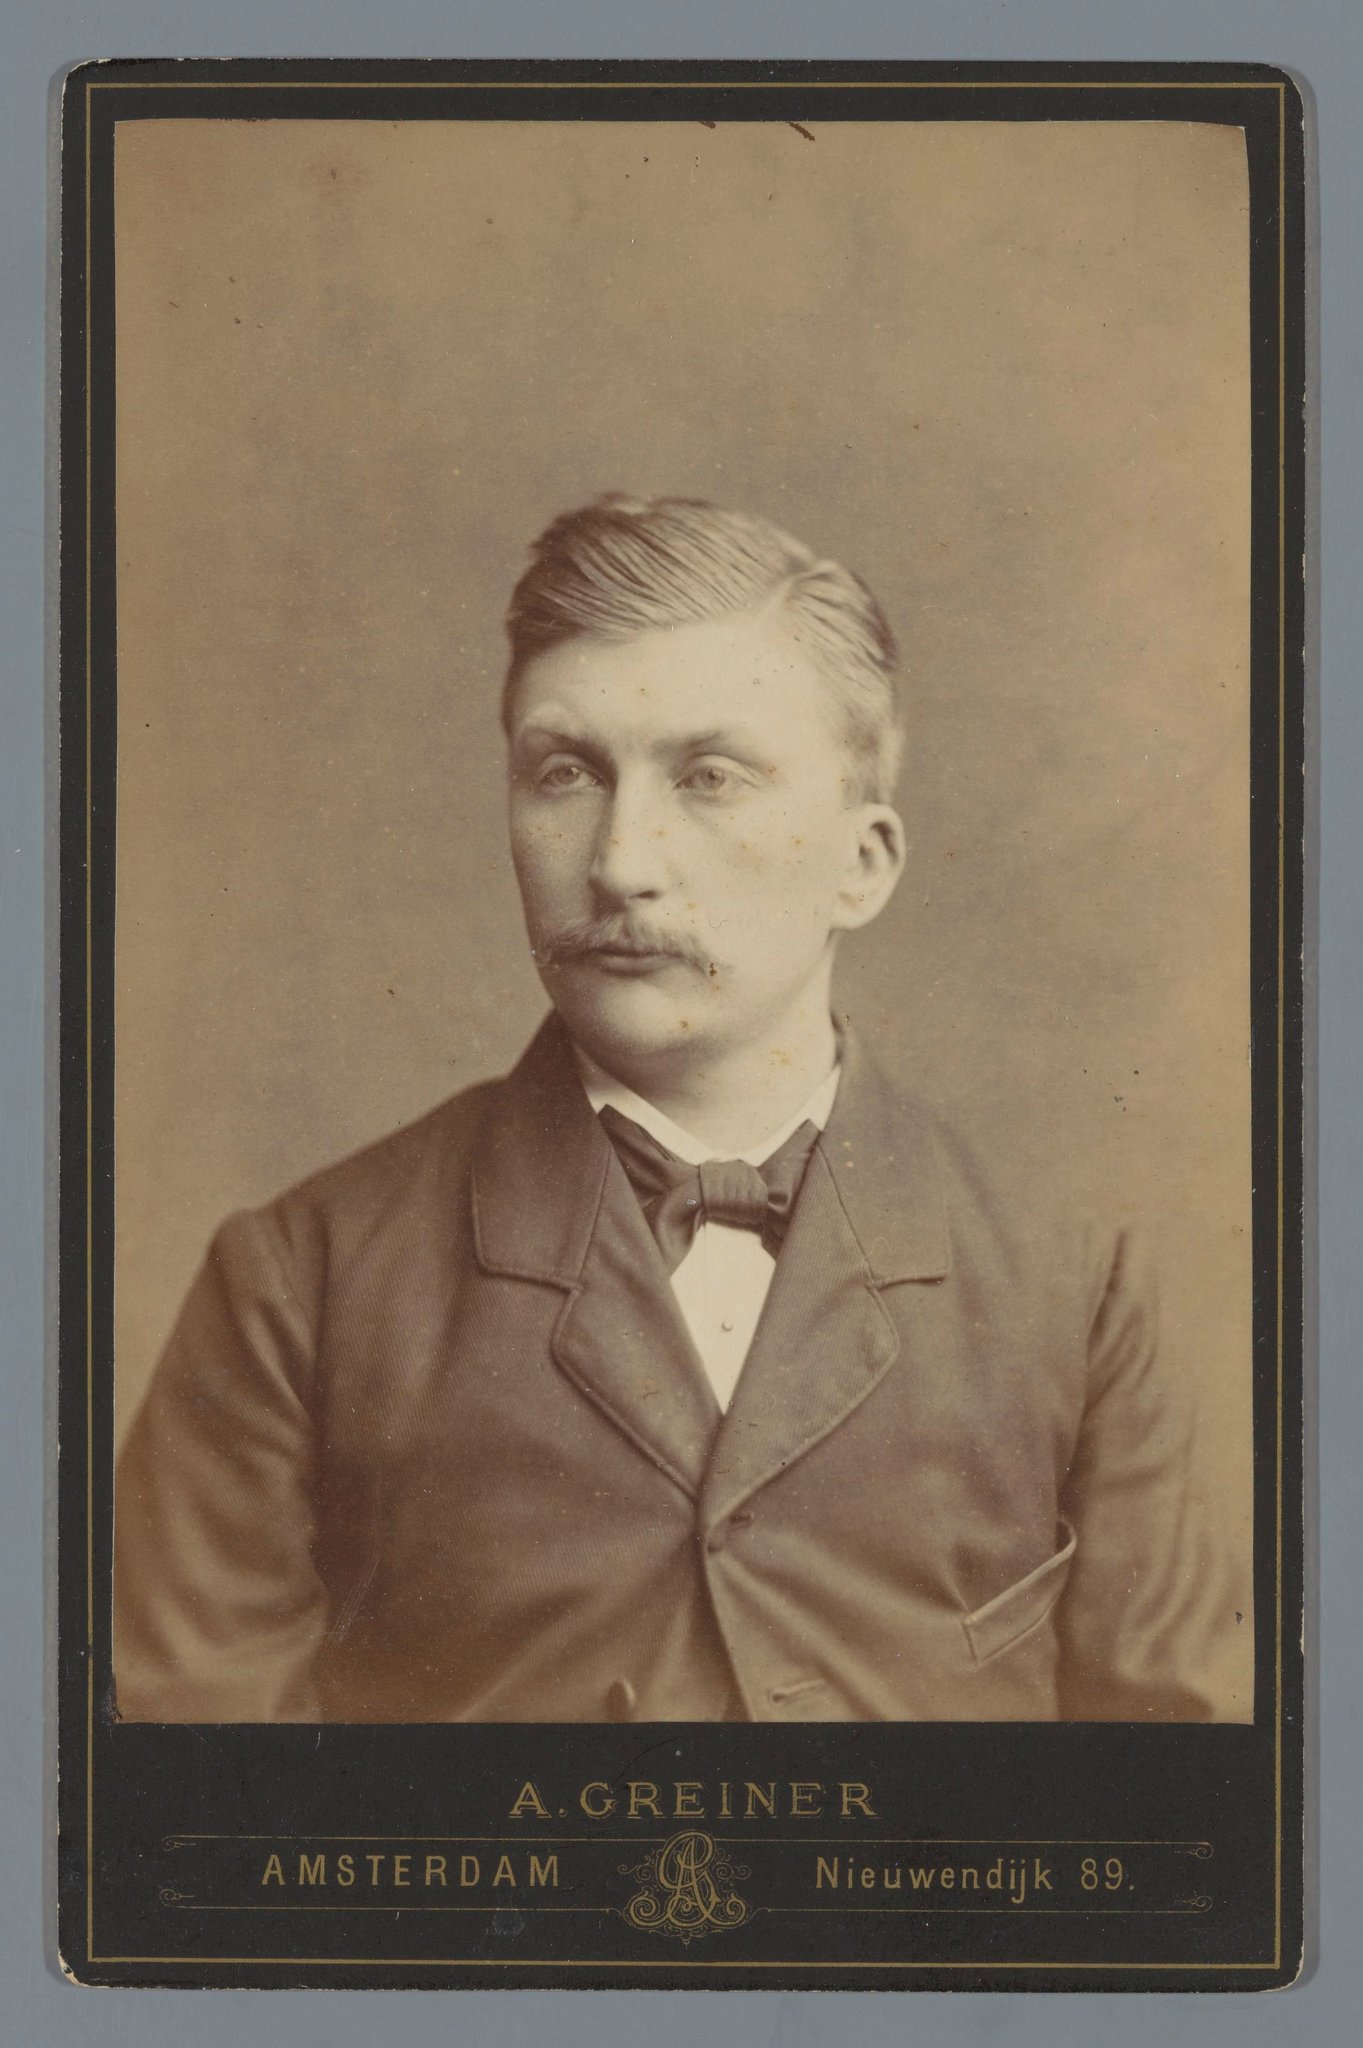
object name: cabinet photograph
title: Portret van een onbekende man met een snor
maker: albert greiner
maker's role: fotograaf, fotostudio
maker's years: 1833-1890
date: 1861-1890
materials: cardboard, photographic support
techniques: albumen print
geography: amsterdam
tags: moustache, adult man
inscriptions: name: ‘A. Greiner Photograaf van H.H. M.M. den Koning en de Koningin der Nederlanden Nieuwendijk L 89 Amsterdam.’